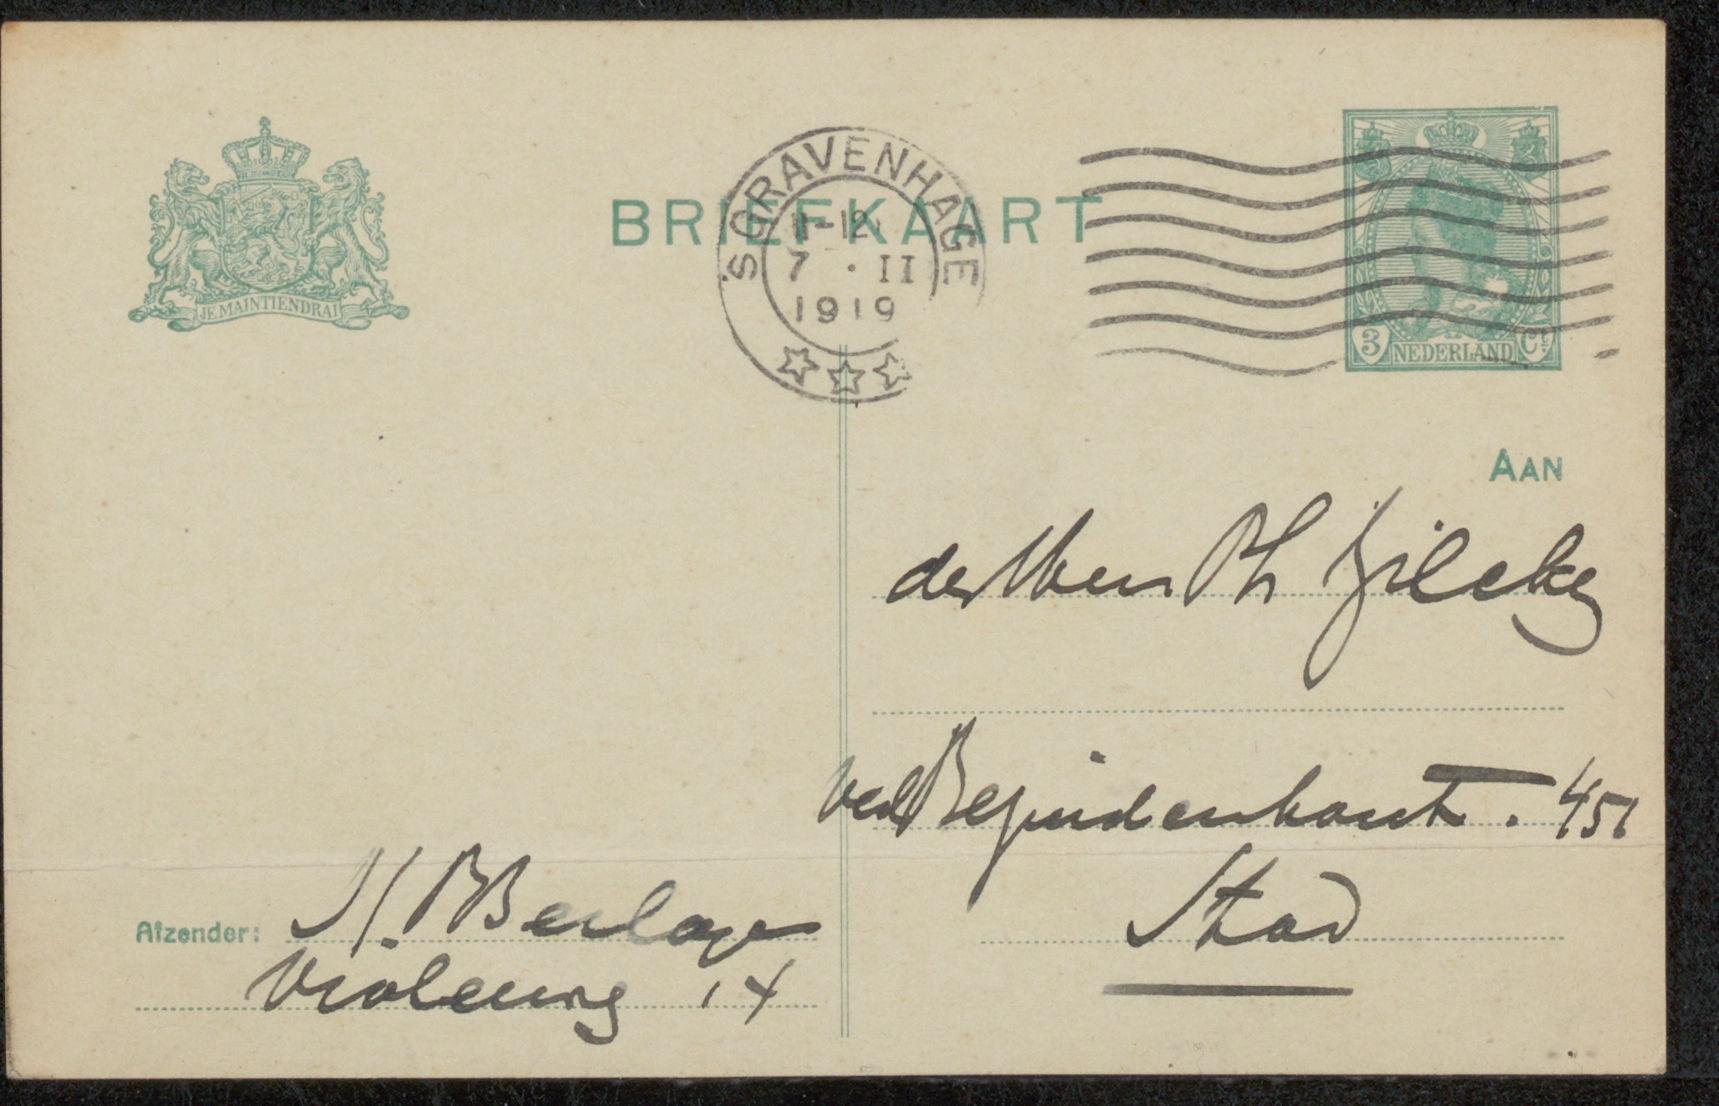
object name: postcard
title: Briefkaart aan Philip Zilcken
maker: hendrik petrus berlage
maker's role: draughtsman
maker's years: 1856-1934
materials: cardboard, ink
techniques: pen, writing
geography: the hague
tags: the hague, painter, draughtsman, philip zilcken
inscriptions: collector's mark: ‘RPK’